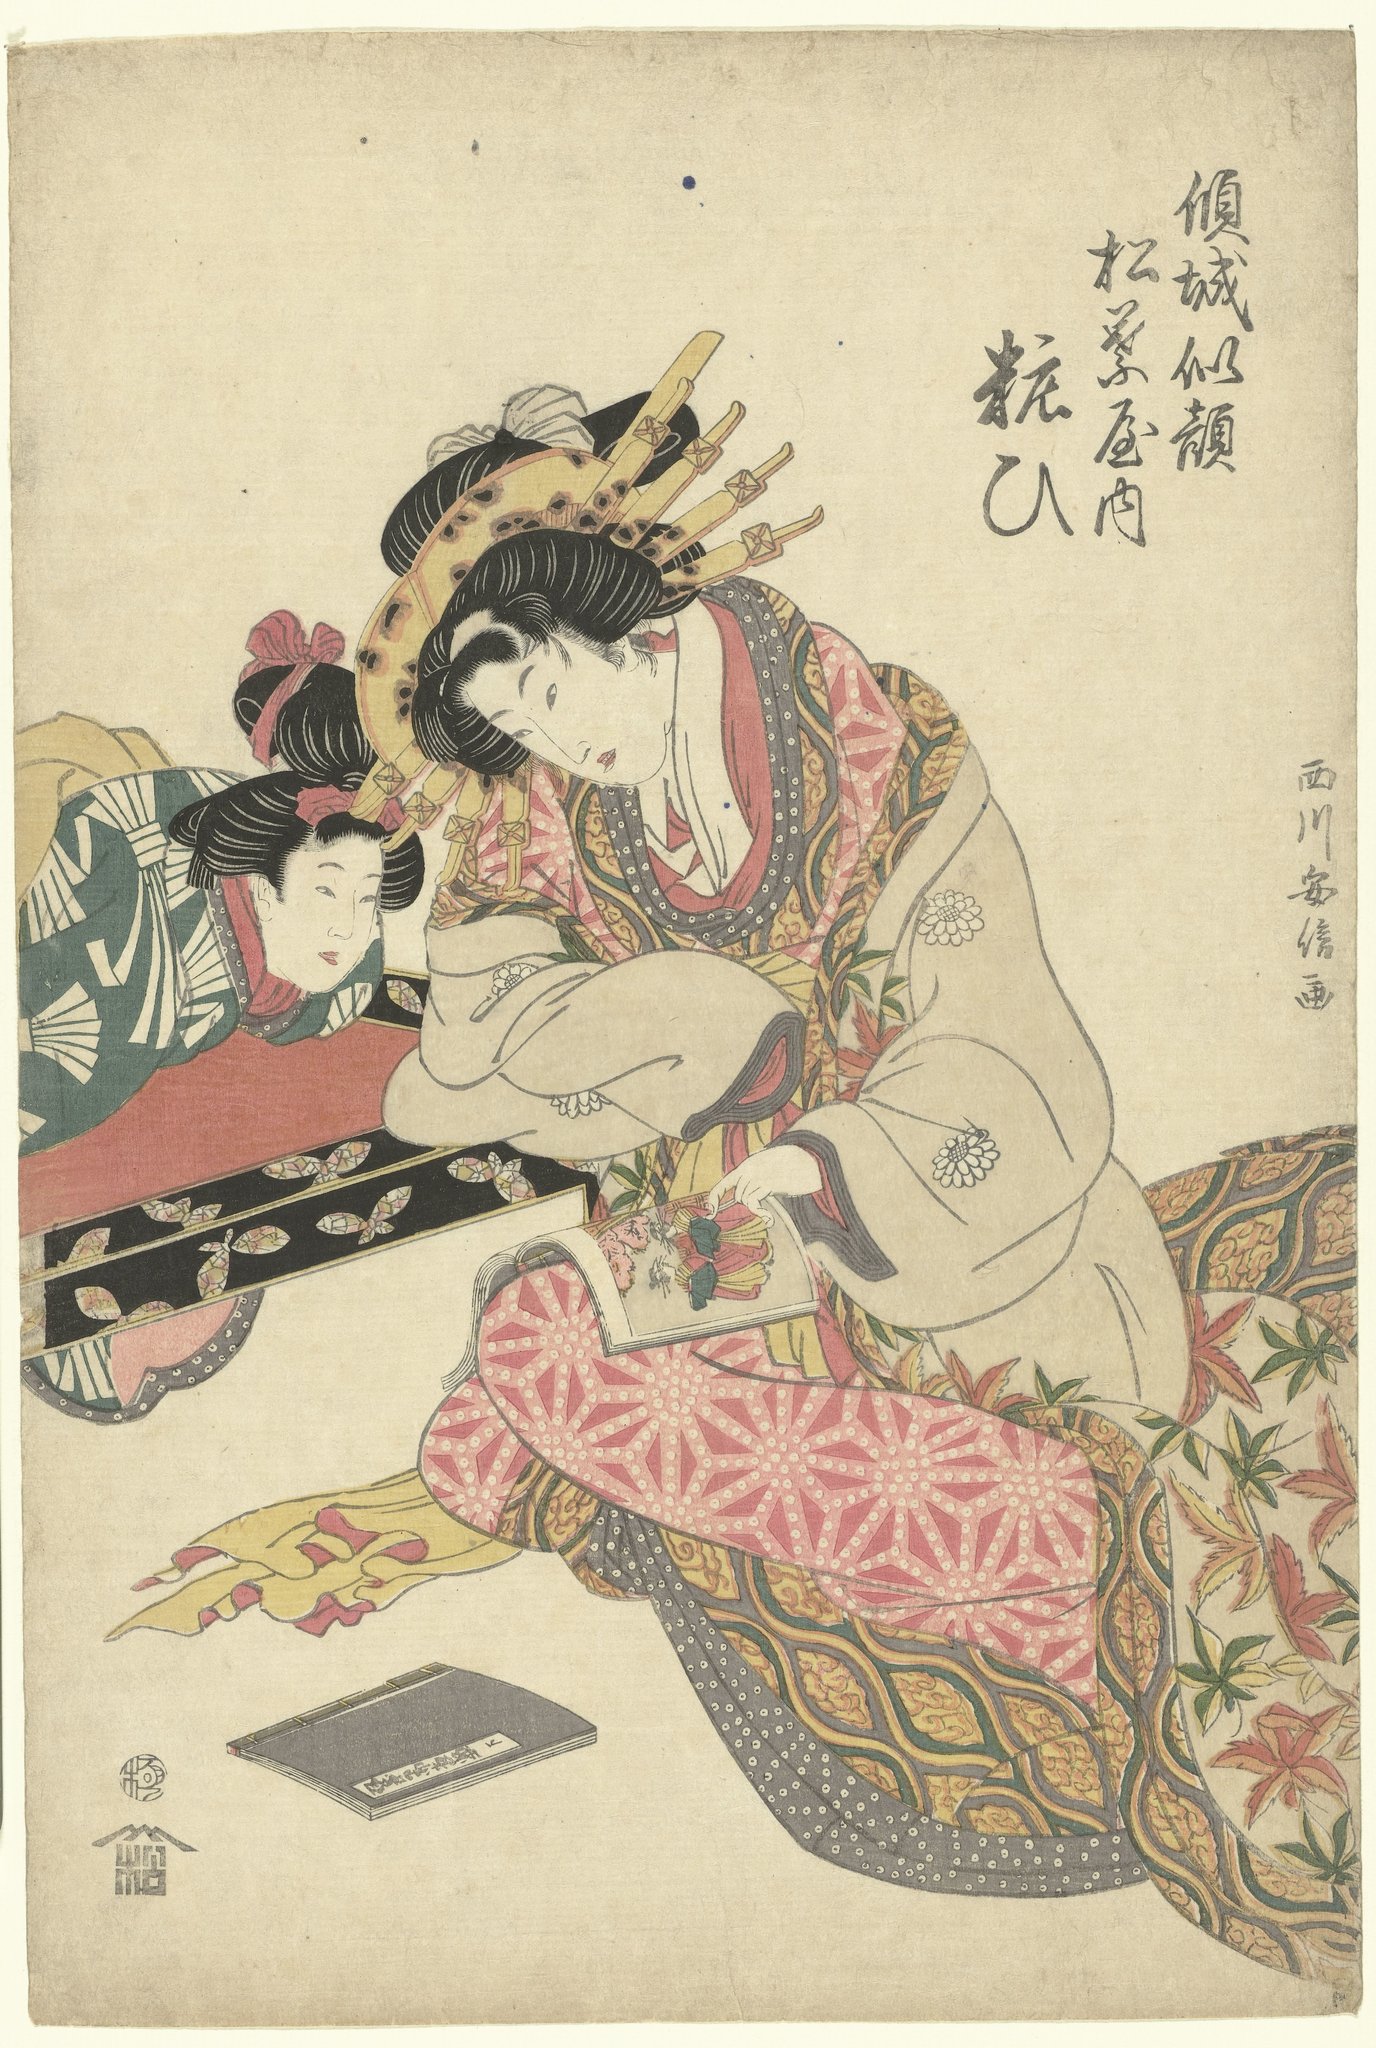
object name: print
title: Geisha en kamuro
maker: kuniyasu utagawa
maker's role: print maker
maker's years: 1794-1832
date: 1811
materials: paper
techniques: woodcut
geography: tokyo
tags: reading a picture book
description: Zittende geisha, een op haar schoot opengeslagen geïllustreerd boek lezend, terwijl haar kamuro, leunend over een lage tafel, meekijkt.